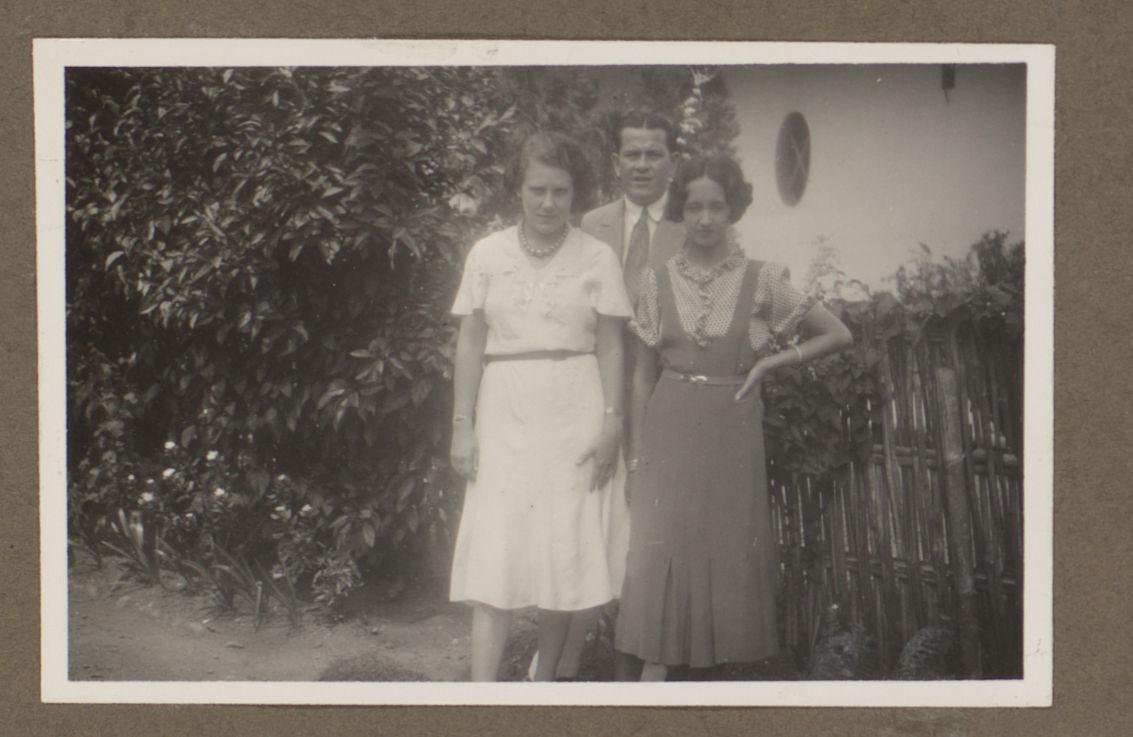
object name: album leaf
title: Groepsportret in een tuin, Batavia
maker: Anonymous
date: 1932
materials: paper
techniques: gelatin silver print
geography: batavia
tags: anonymous historical persons portrayed in a group, in a group-portrait, batavia